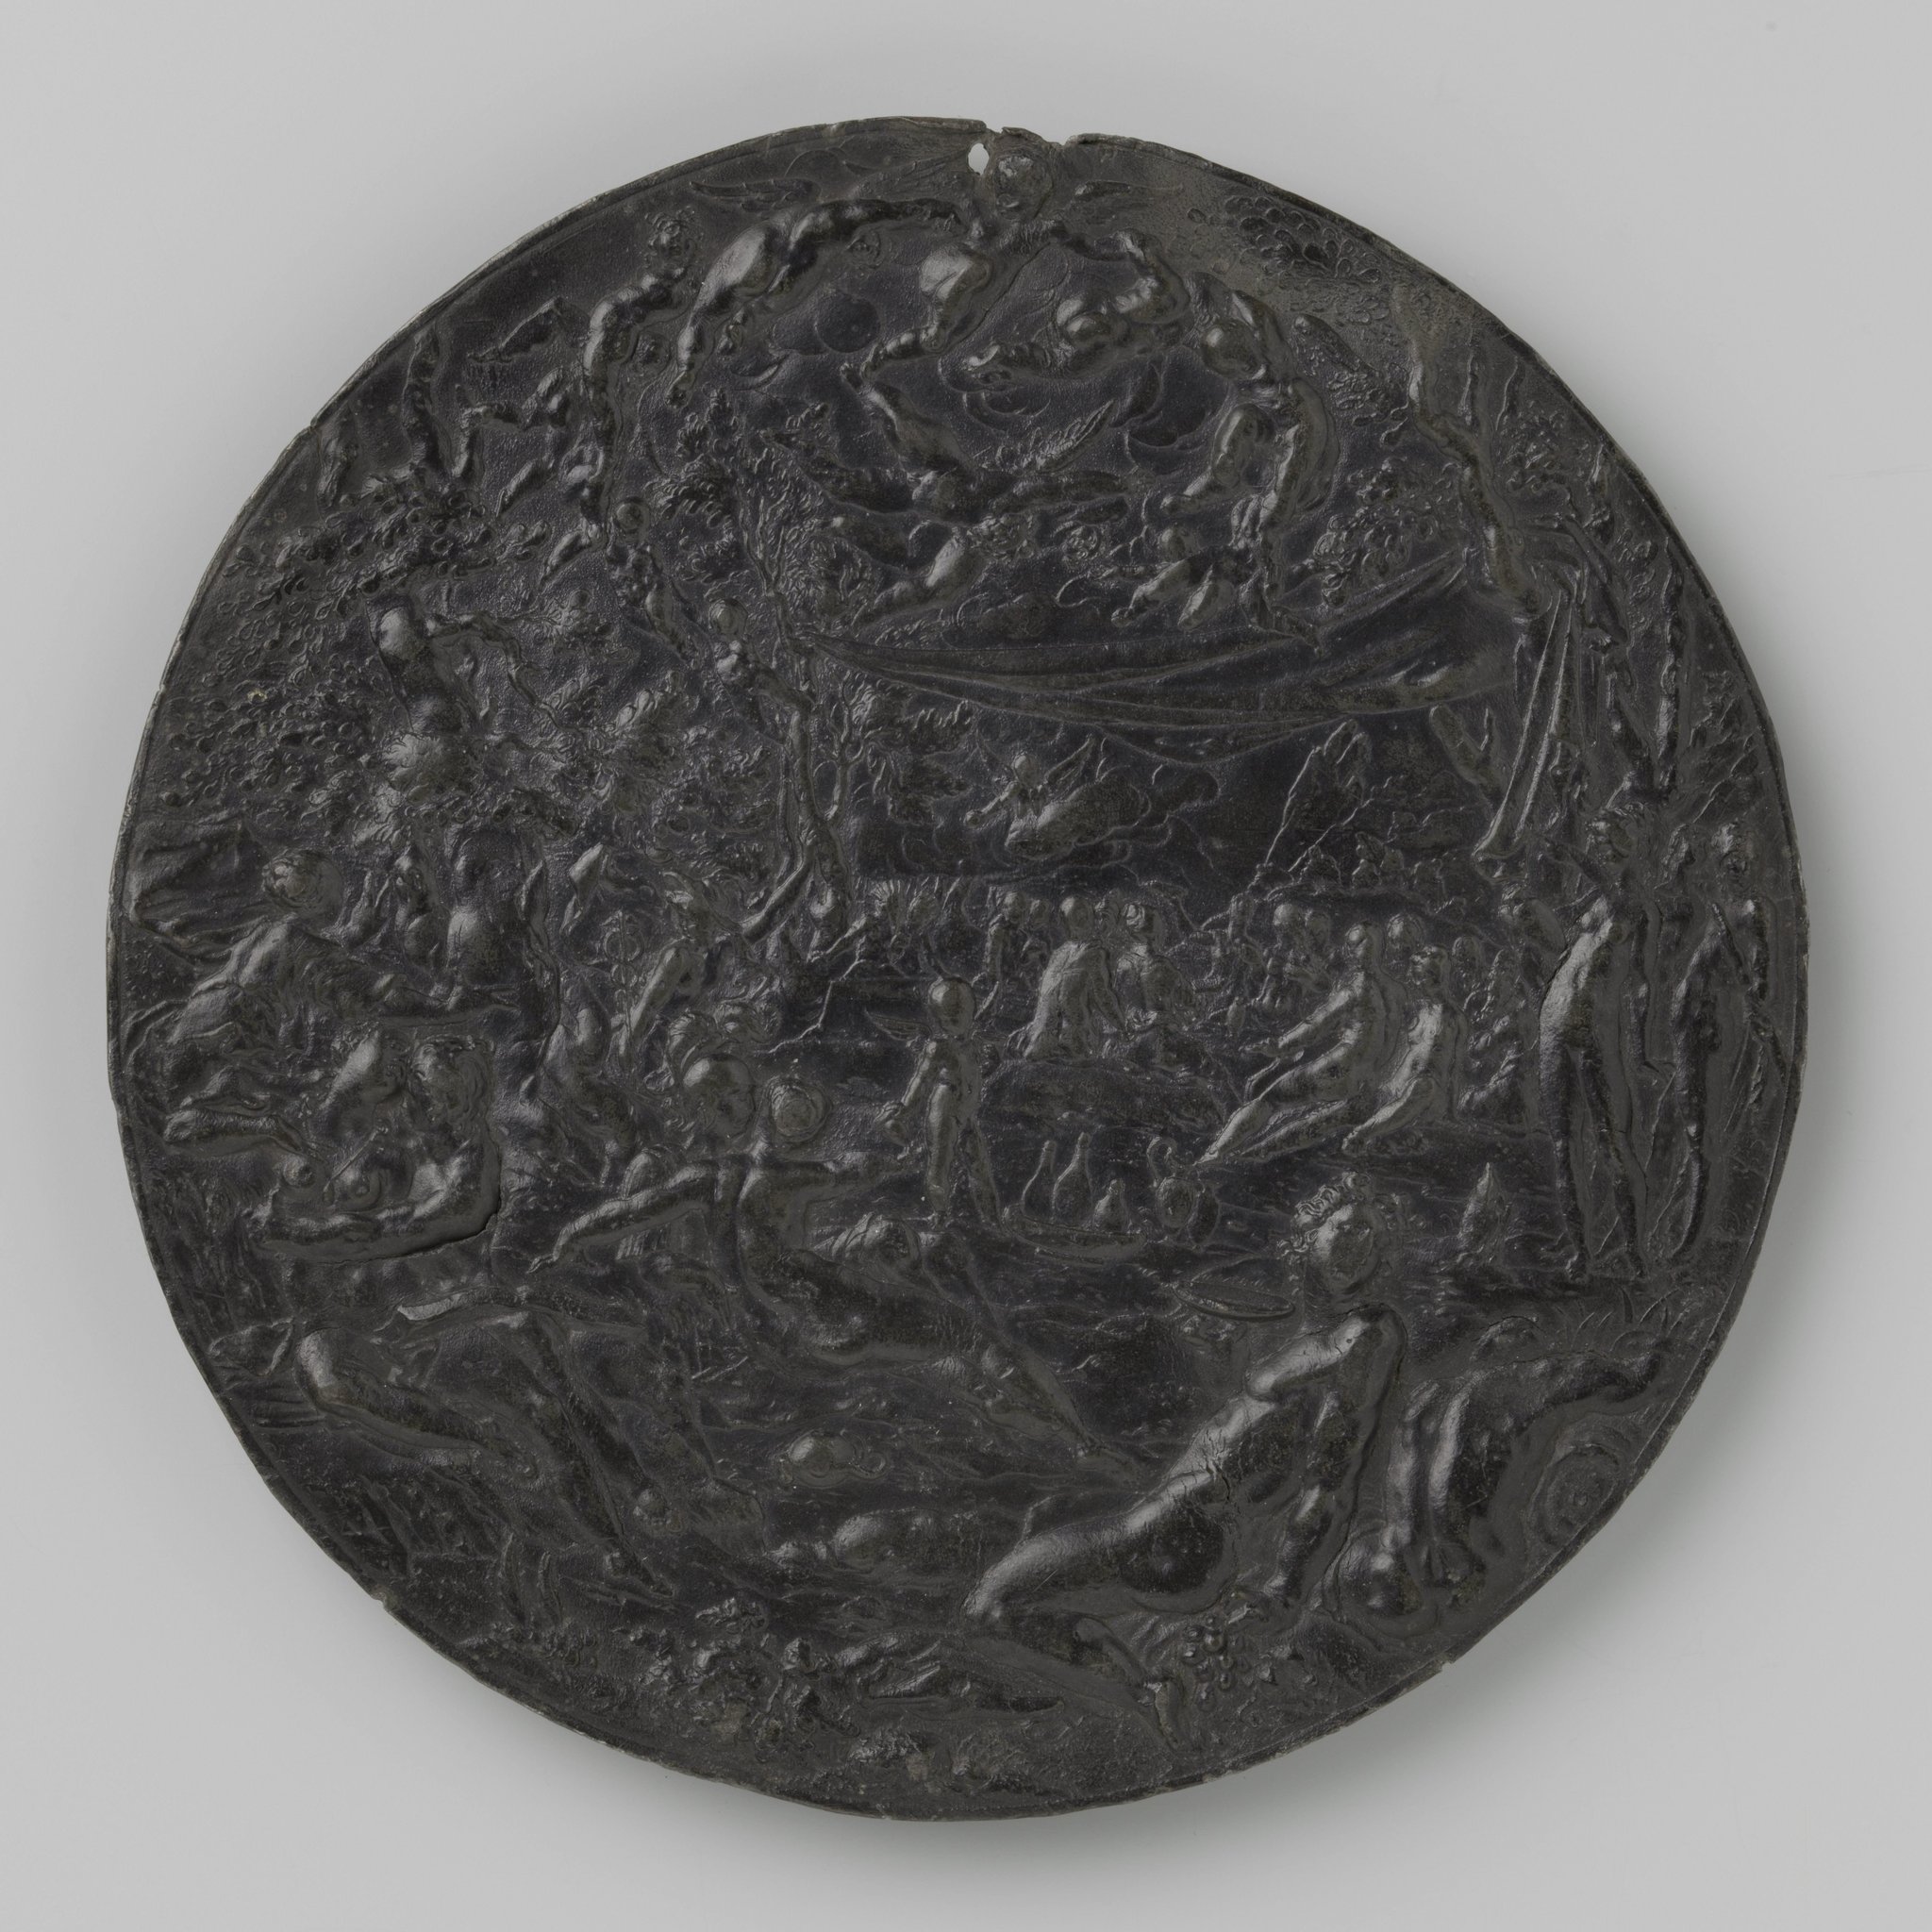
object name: plaque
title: Bruiloft van Peleus en Thetis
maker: adam van vianen (i)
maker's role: draughtsman, print maker, silversmith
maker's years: 1568-1627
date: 1600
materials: lead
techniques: casting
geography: utrecht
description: Ronde, loden plaquette. Rechts op de voorgrond Bacchus en een stroomgod. Links voor een boomgroep verliefde godenparen. Verder naar het tweede plan verschillende naakte, Olympische figuren, terwijl op de achtergrond het bruidspaar is gezeten om een gedekte tafel te midden van een groot gezelschap onder een uitgespannen velum. Daarboven een zweem liefde-godjes.